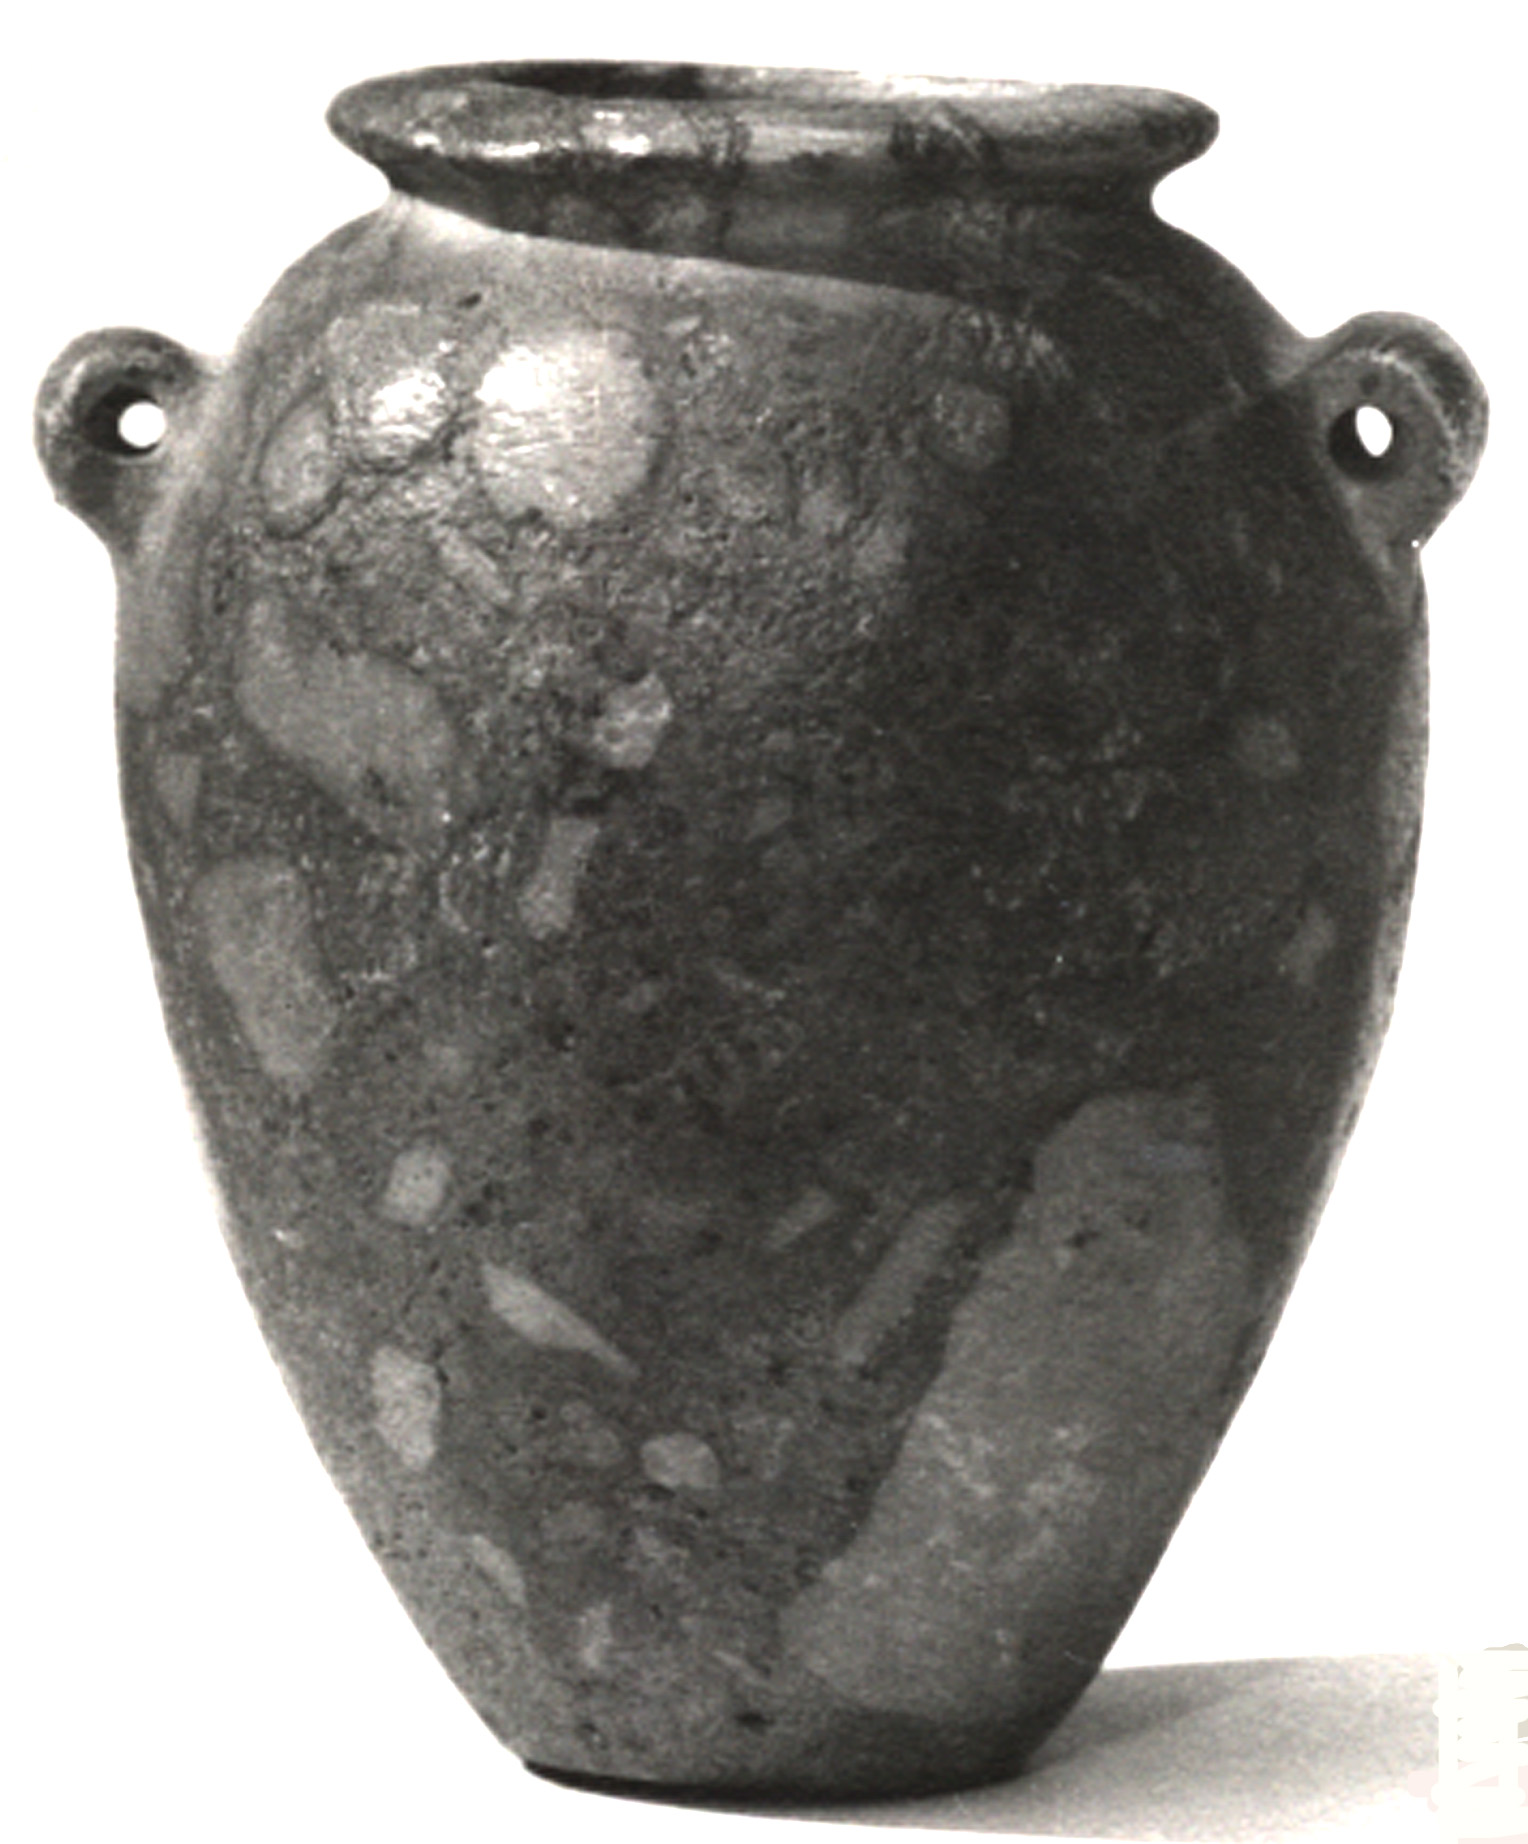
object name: jar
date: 3850-2960 BCE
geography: egypt